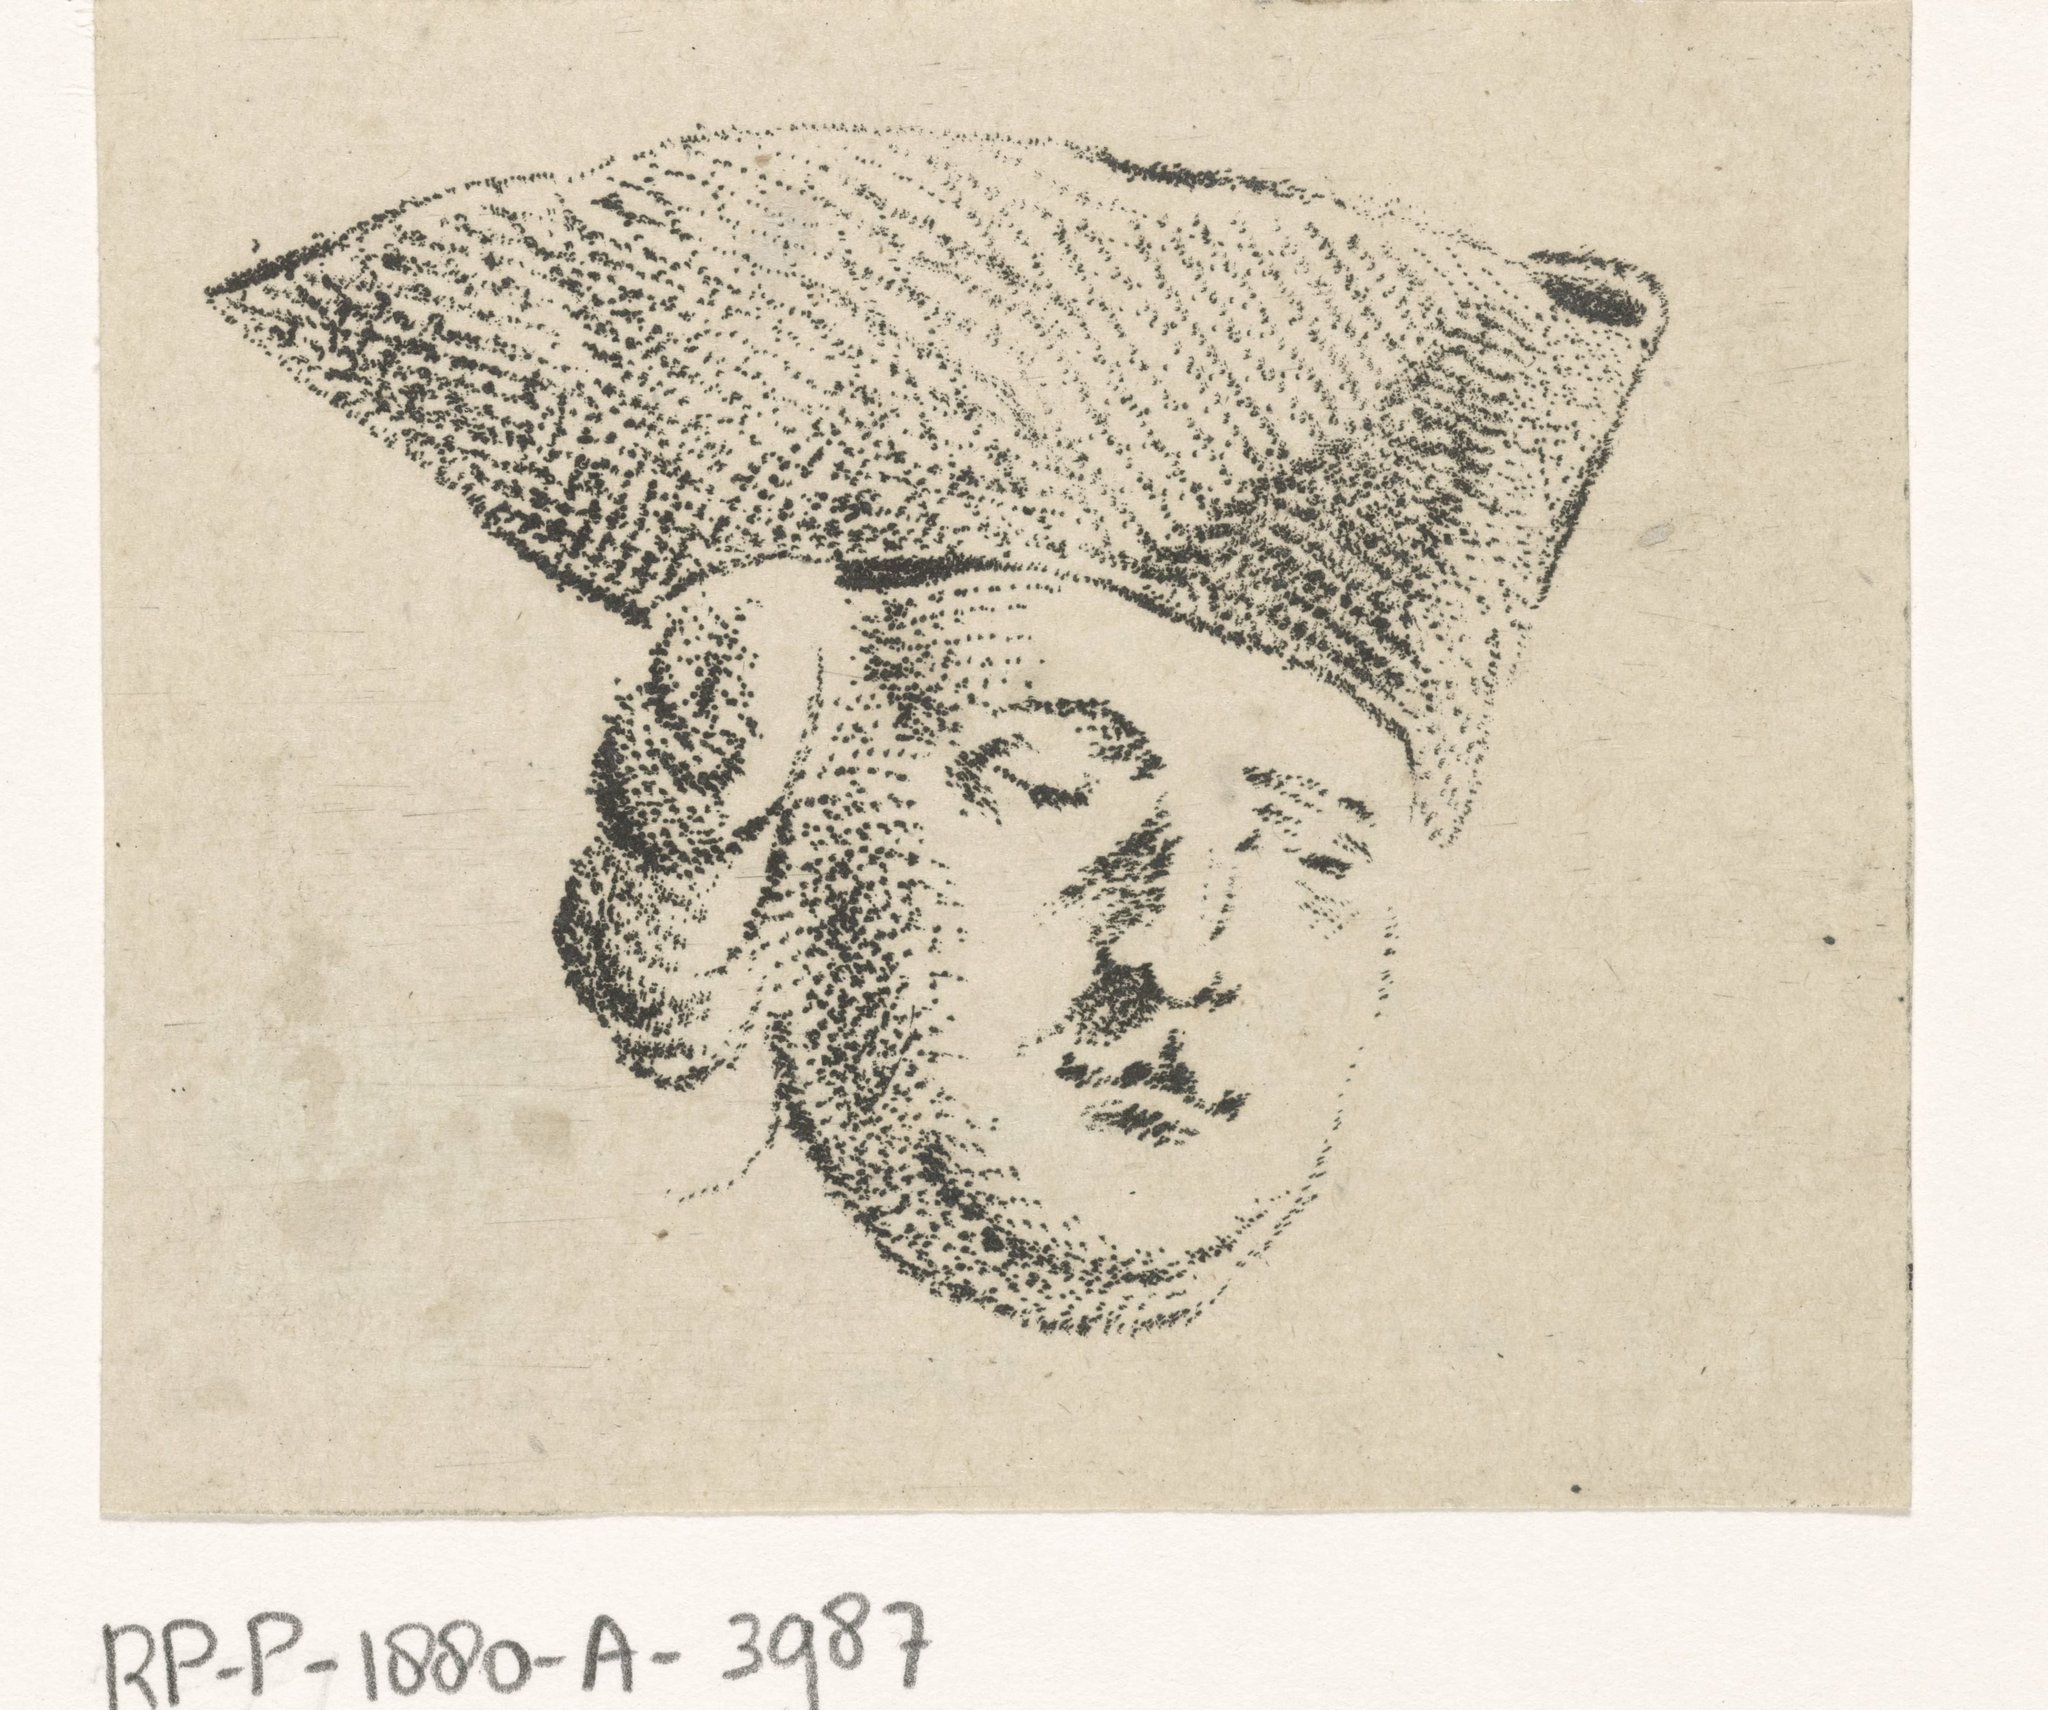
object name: print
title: Manskop met steek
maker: caspar jacobsz. philips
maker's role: draughtsman, print maker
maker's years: 1732-1789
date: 1752-1789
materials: paper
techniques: etching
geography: amsterdam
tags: head-gear: tricorn (+ men's clothes), head (human)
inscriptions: collector's mark: Lugt 2228